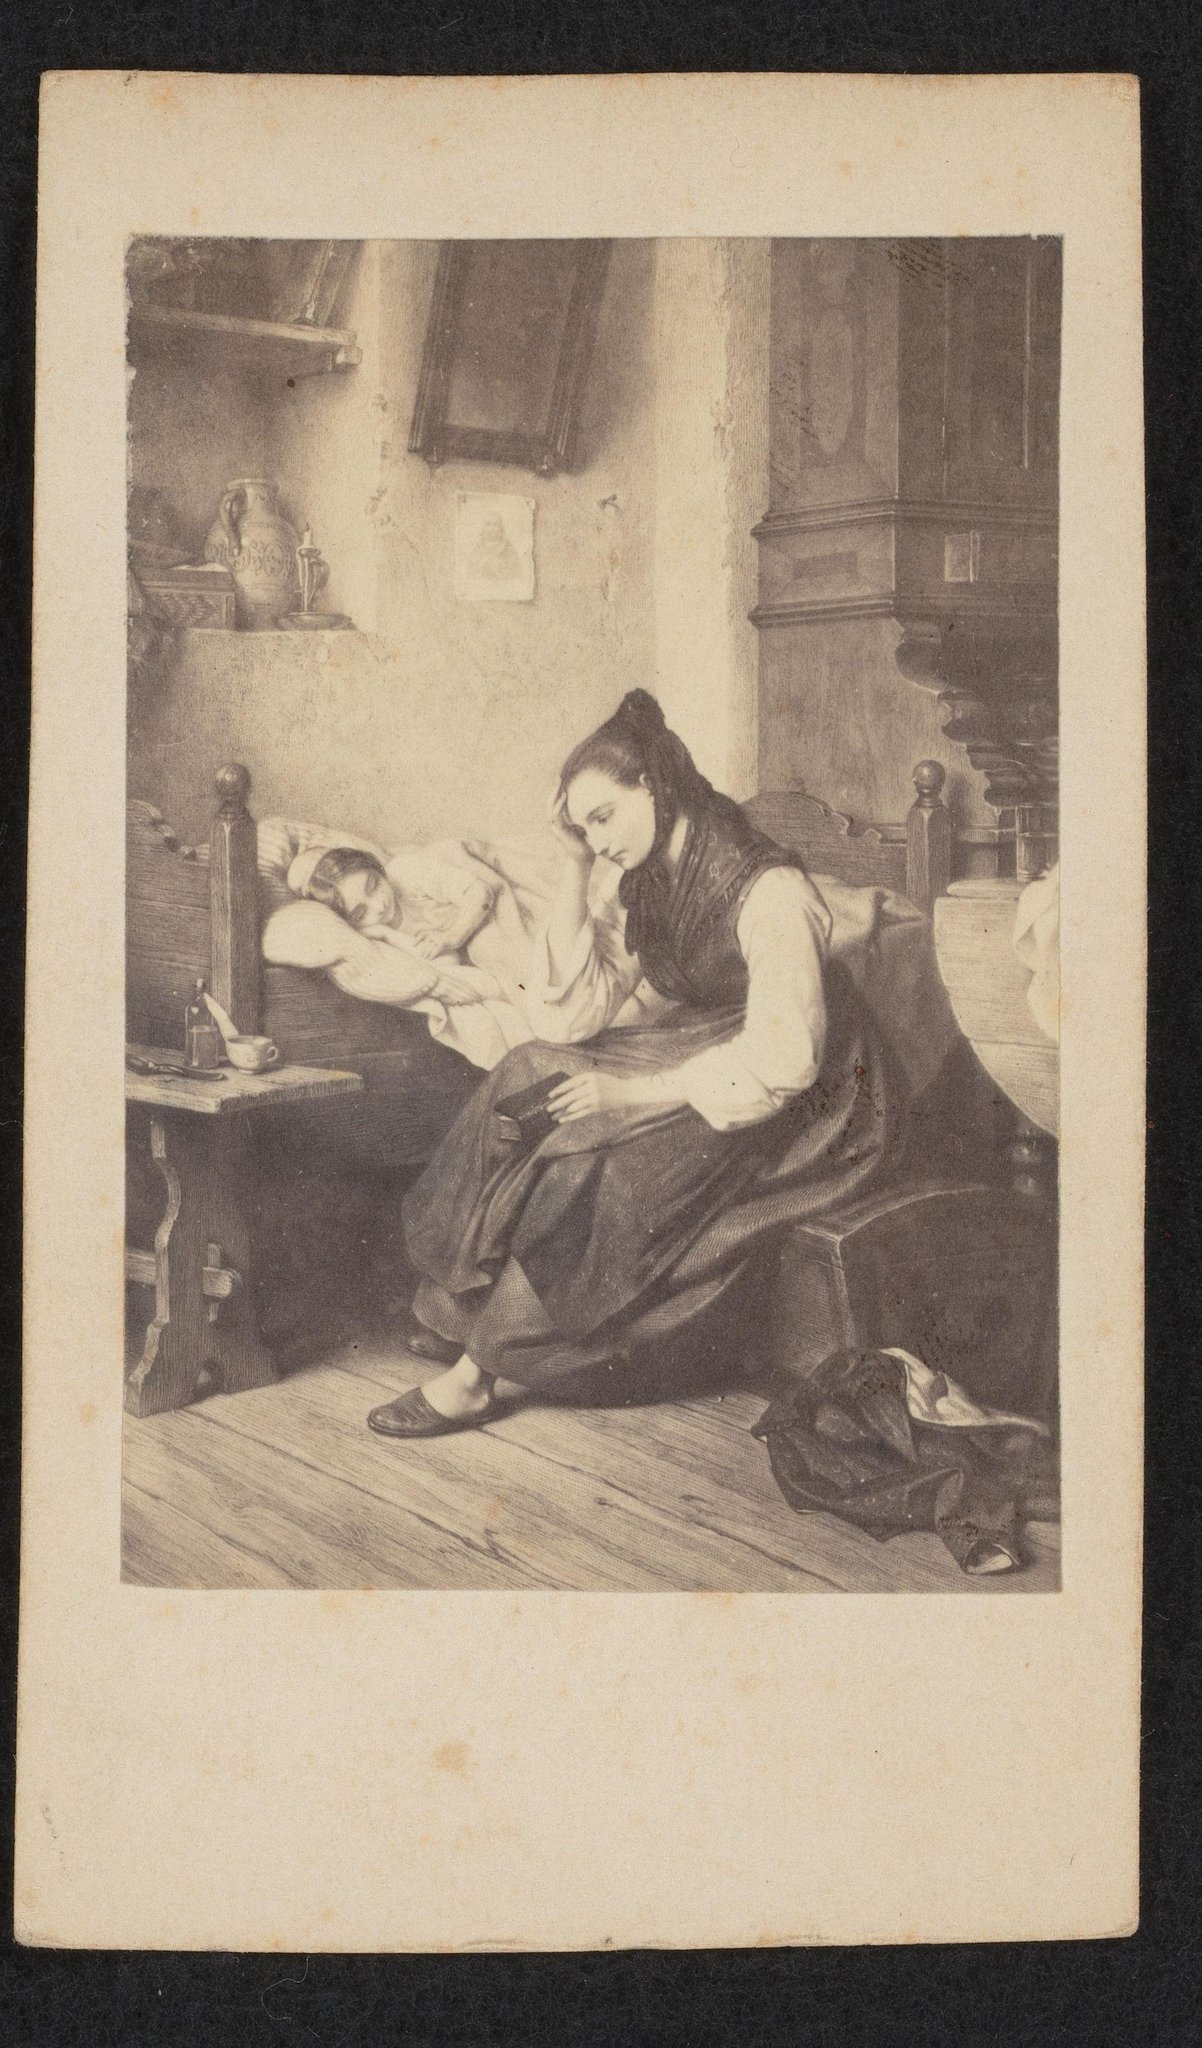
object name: reproduction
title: Fotoreproductie van een schilderij, moeder waakt bij liggend dochtertje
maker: Anonymous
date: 1860-1900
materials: cardboard, photographic support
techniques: albumen print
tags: watching a sleeping child